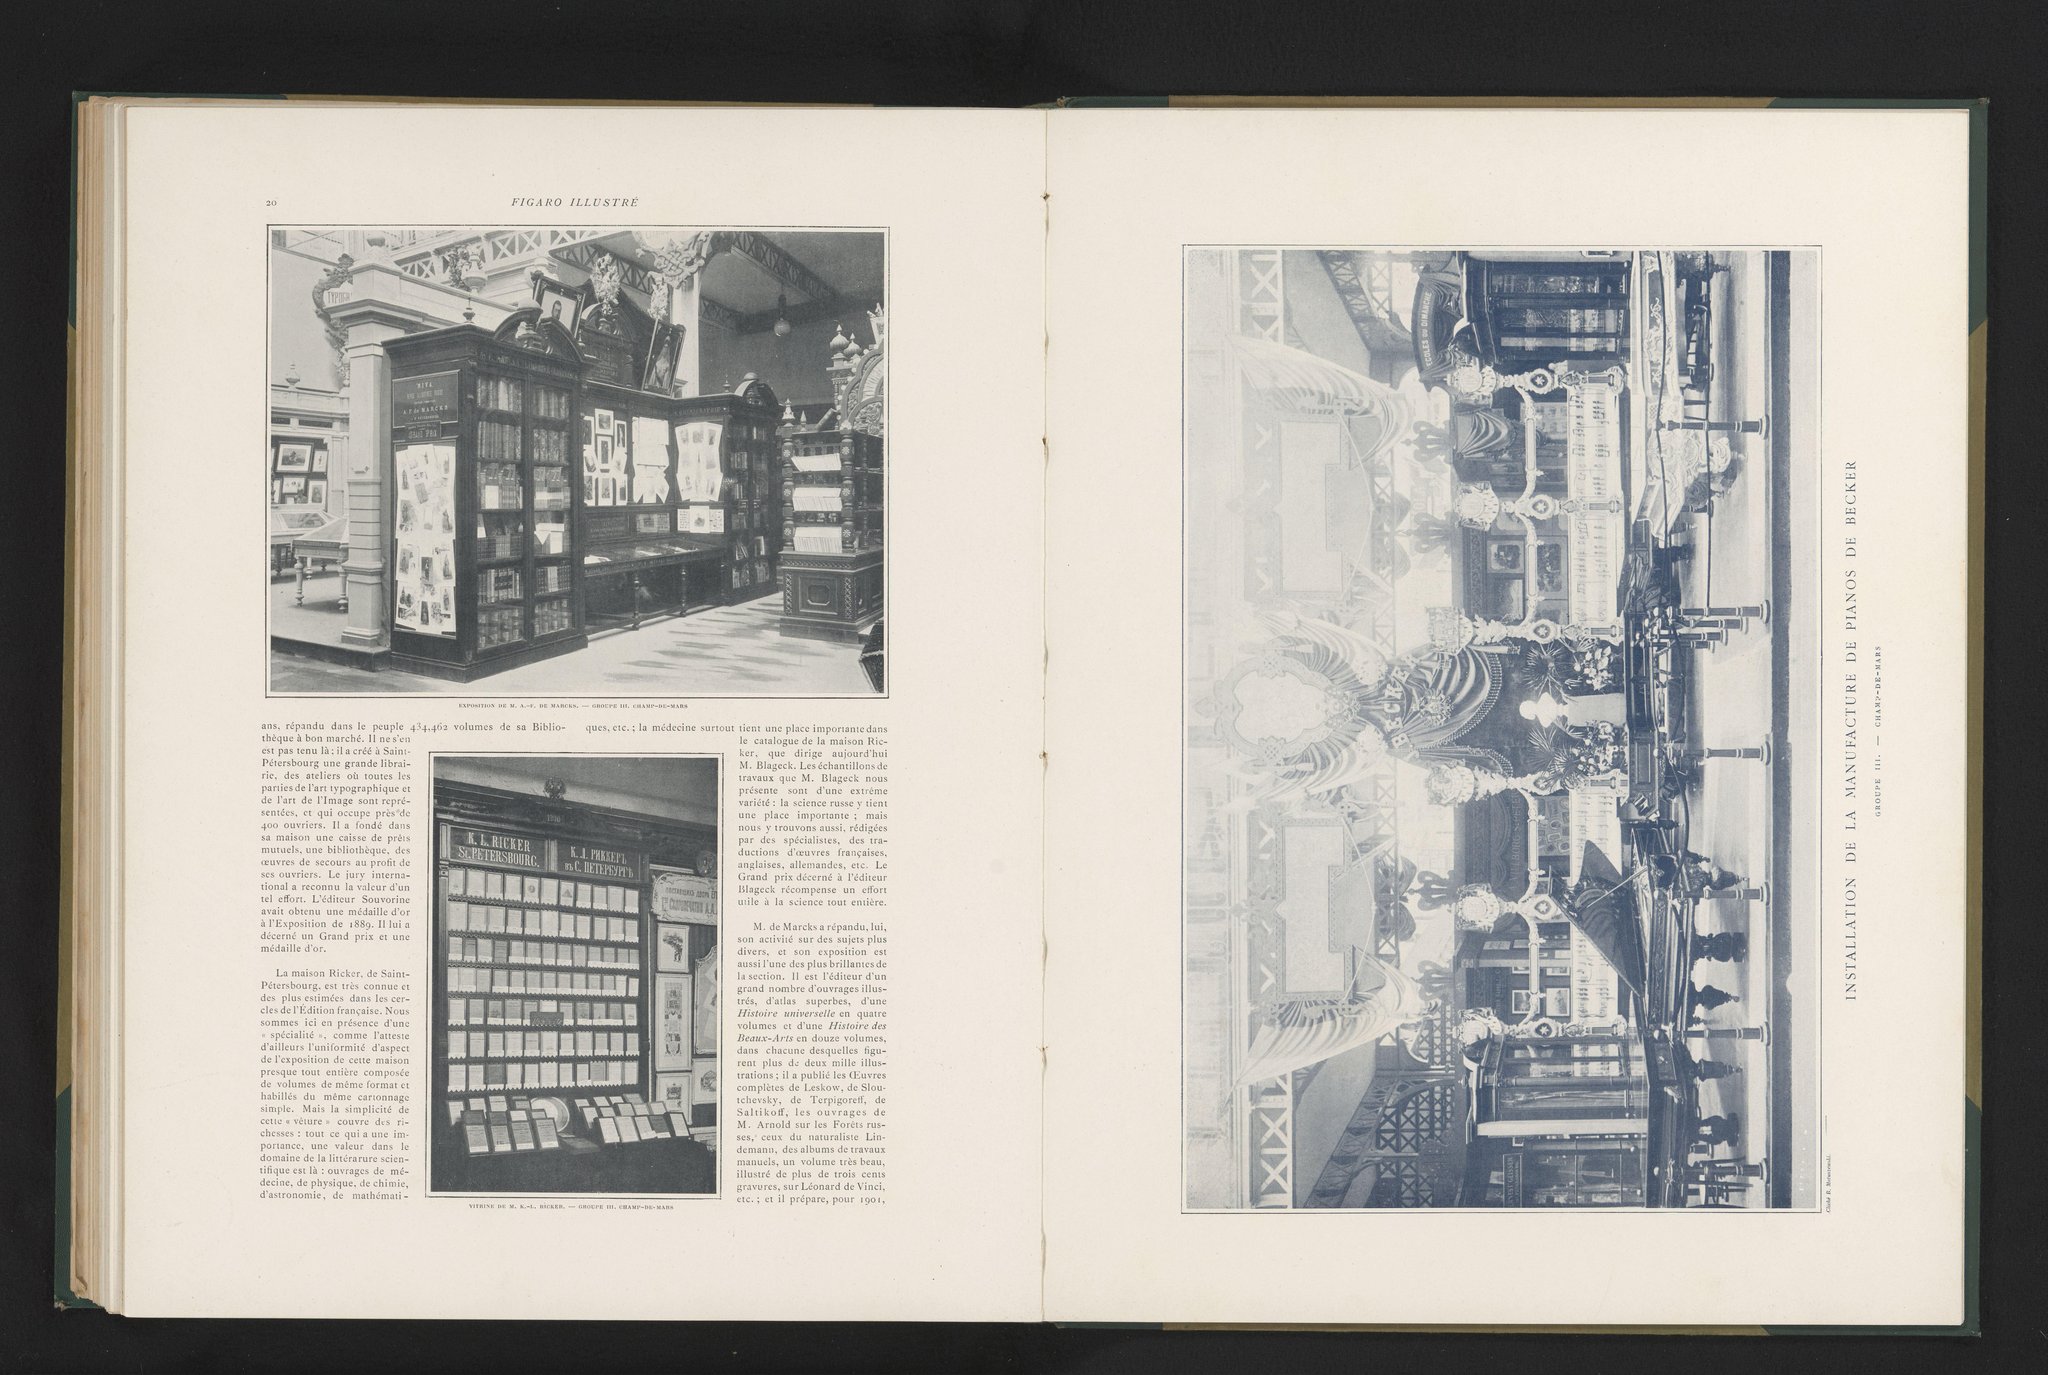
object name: photomechanical print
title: Installation de la manufacture de pianos de Becker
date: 1885-1901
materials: paper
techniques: autotype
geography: paris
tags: grand piano, world fair, world exhibition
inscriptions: inscription: ‘Groupe III. - Champ-de-Mars’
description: Prent op pagina 21 van Figaro-Illustré (Décembre 1900 (2)).